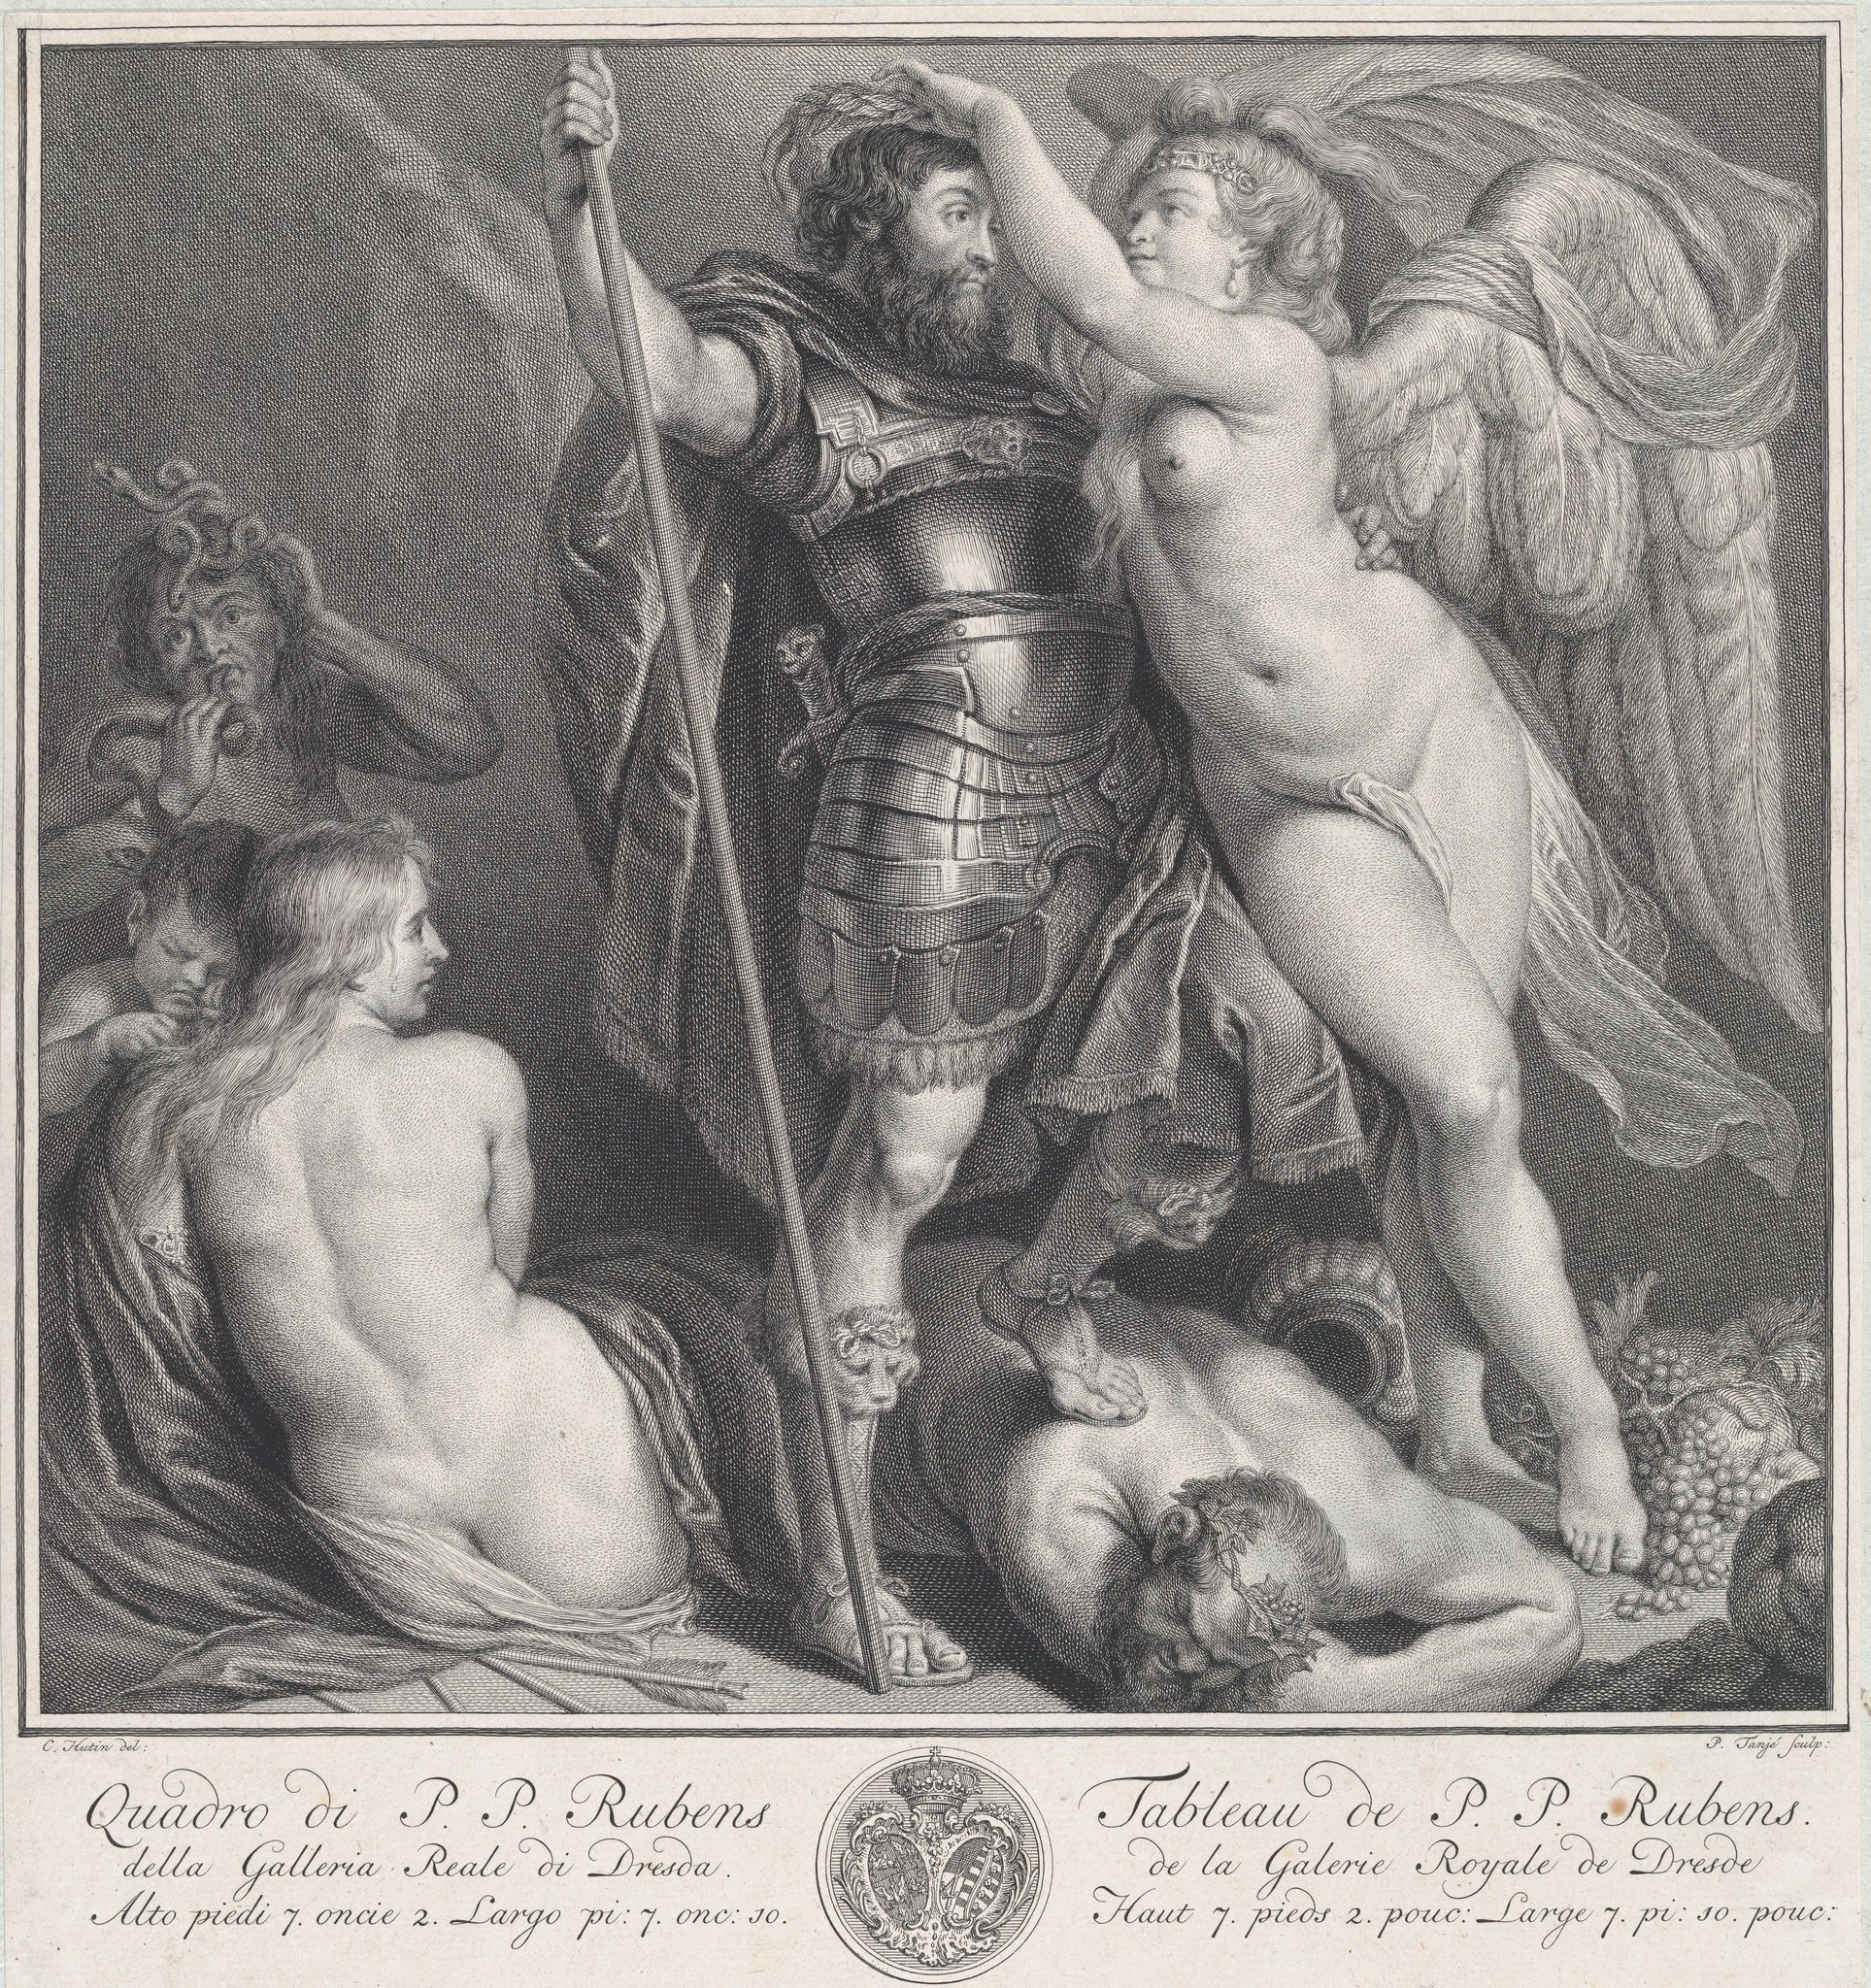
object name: print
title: Hero crowned by Victory, who places a laurel wreath on his head, Venus and Cupid at left, Envy at left in the background, Silenus on the ground, under the hero's foot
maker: pieter tanjé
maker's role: artist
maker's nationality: dutch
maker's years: 1706-1761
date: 1735-1761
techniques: engraving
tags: cupid,silenus,venus,victory,wreaths